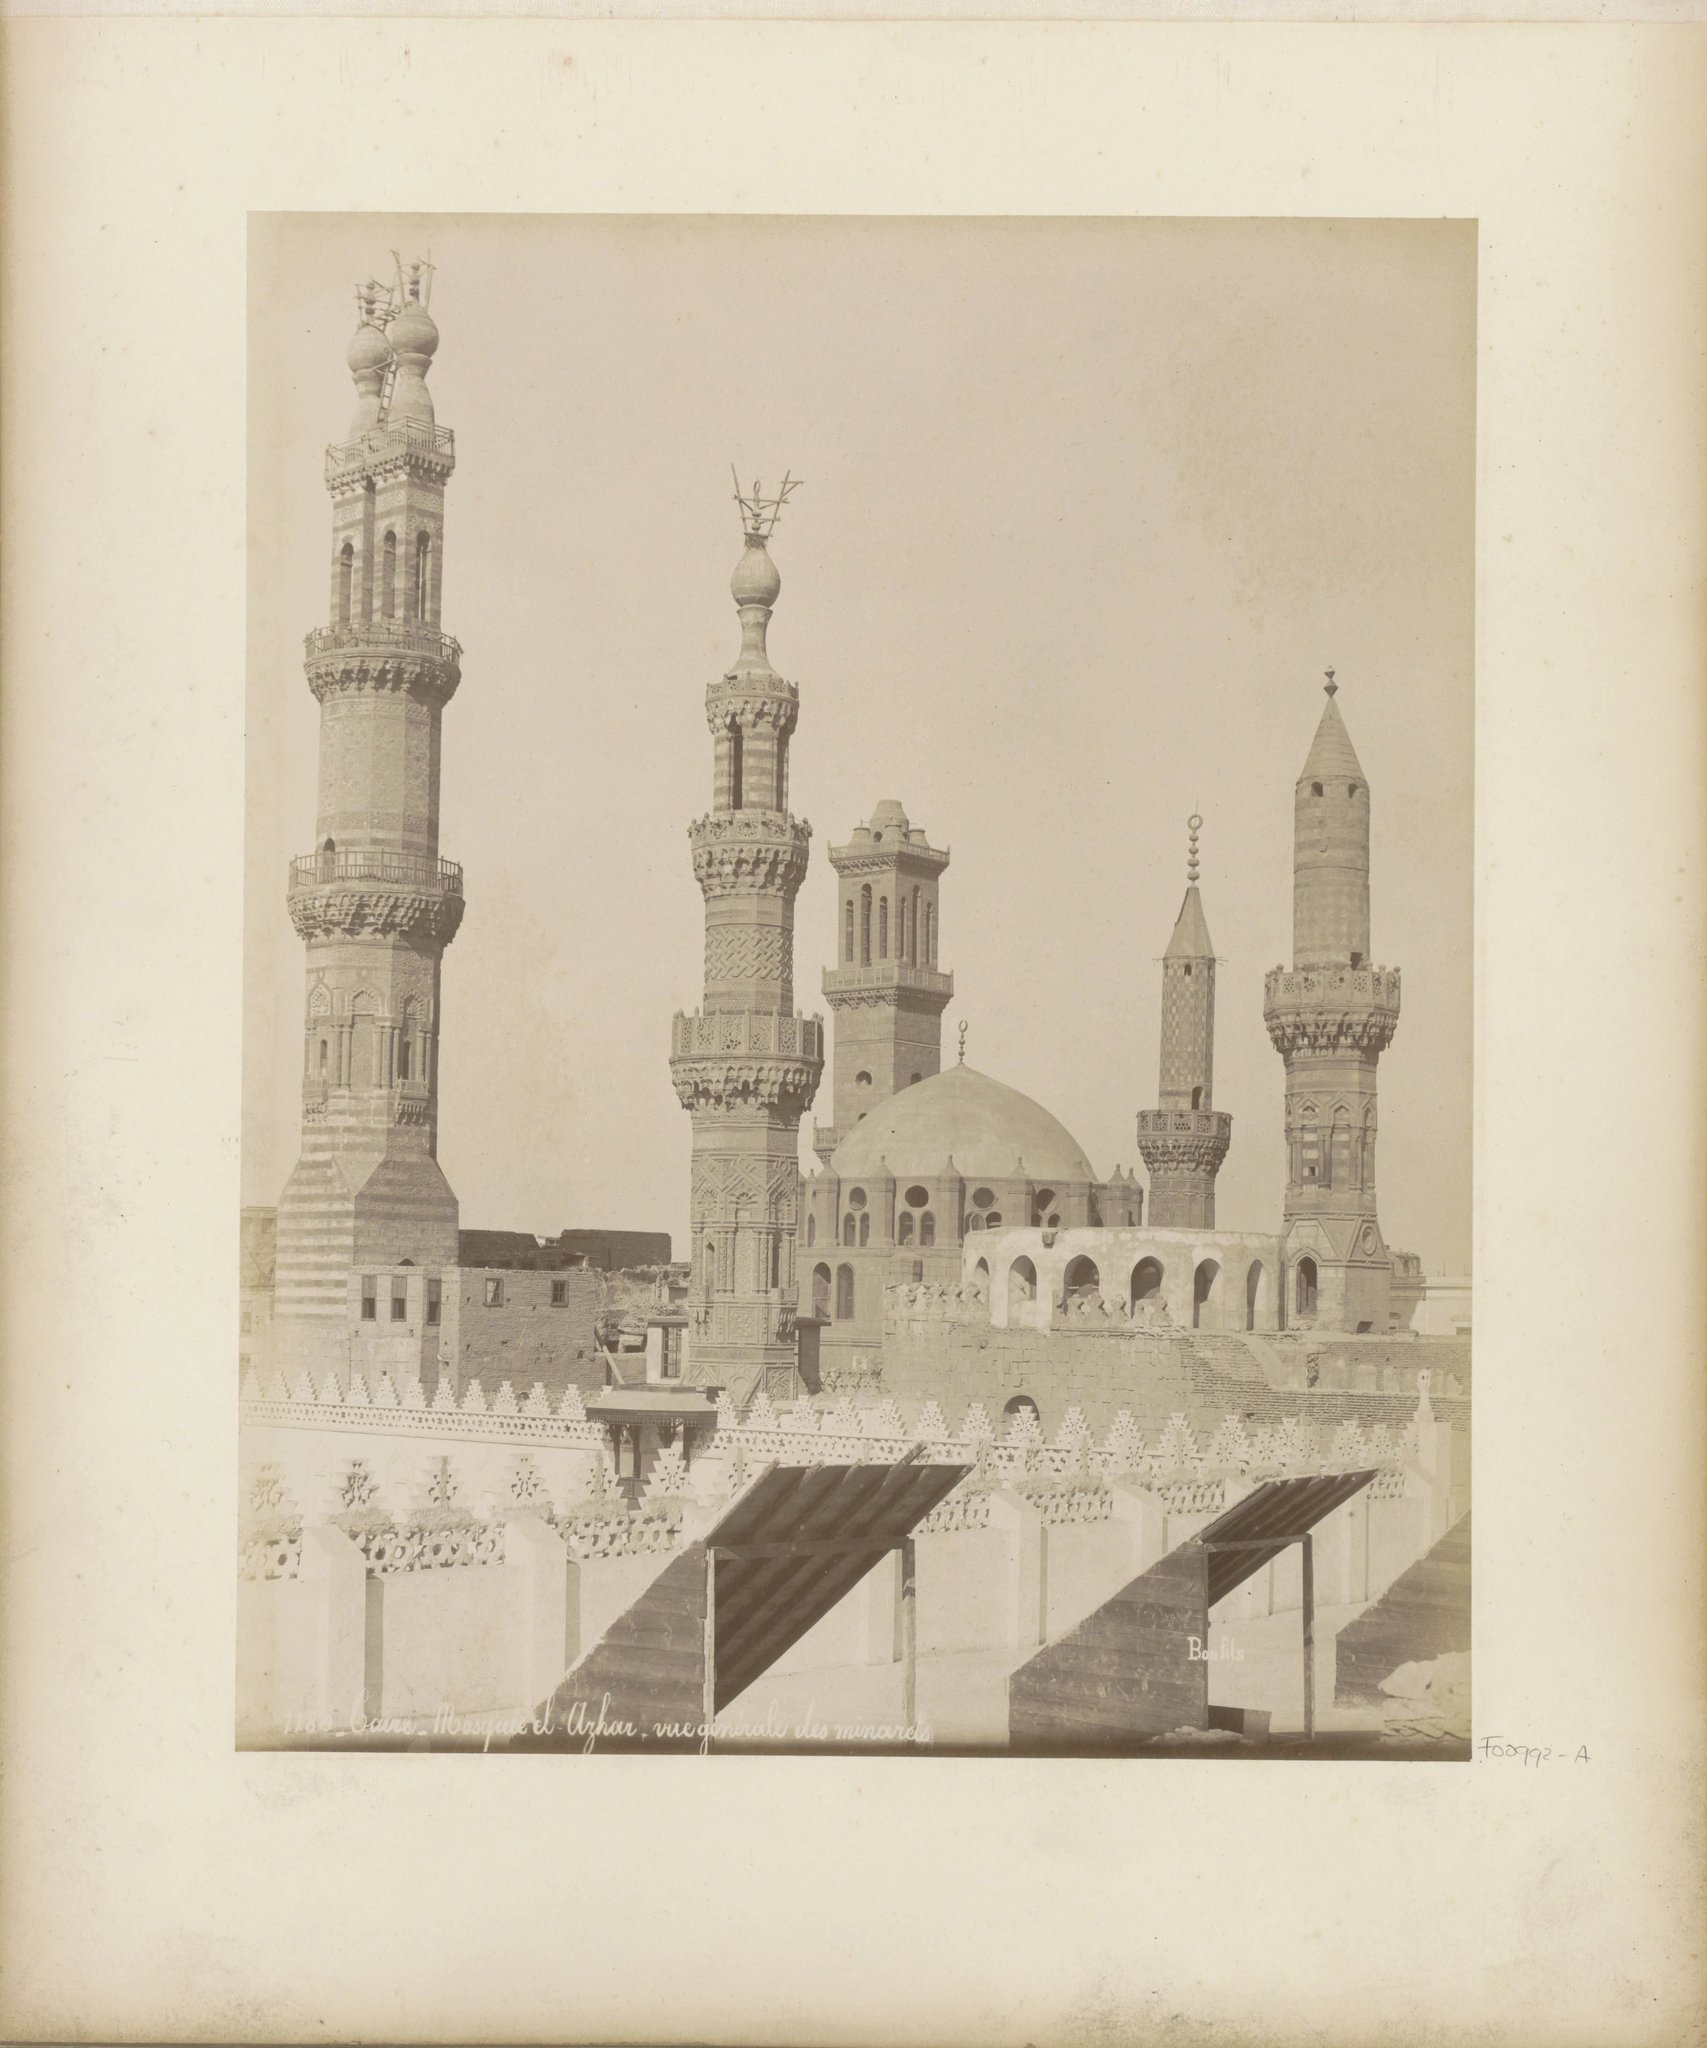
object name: photograph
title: Gezicht op de minaretten van de Al-Azhar-moskee in Caïro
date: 1870-1898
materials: cardboard, paper, photographic support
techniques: albumen print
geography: cairo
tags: temple, shrine ~ islam, mohammedanism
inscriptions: negative number: ‘1180’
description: Onderdeel van Reisalbum met 80 foto's van Egypte.